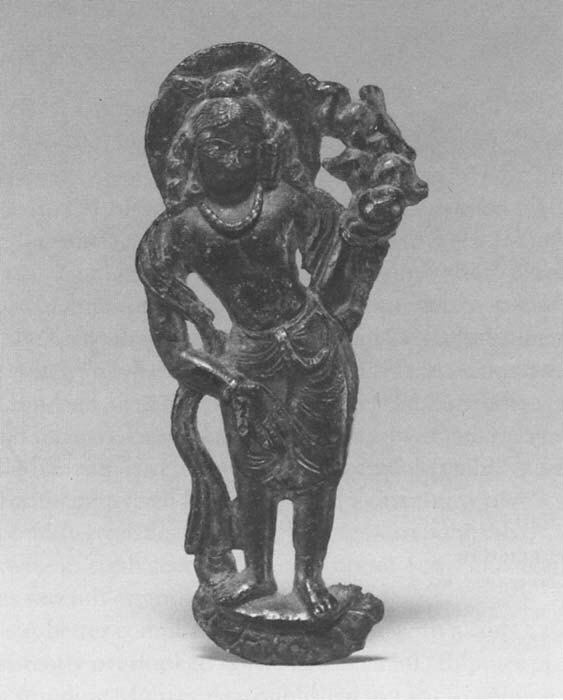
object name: fragment of halo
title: Standing Bodhisattva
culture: pakistani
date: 501-700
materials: bronze, silver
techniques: inlay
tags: swat valley,buddhism,bodhisattvas